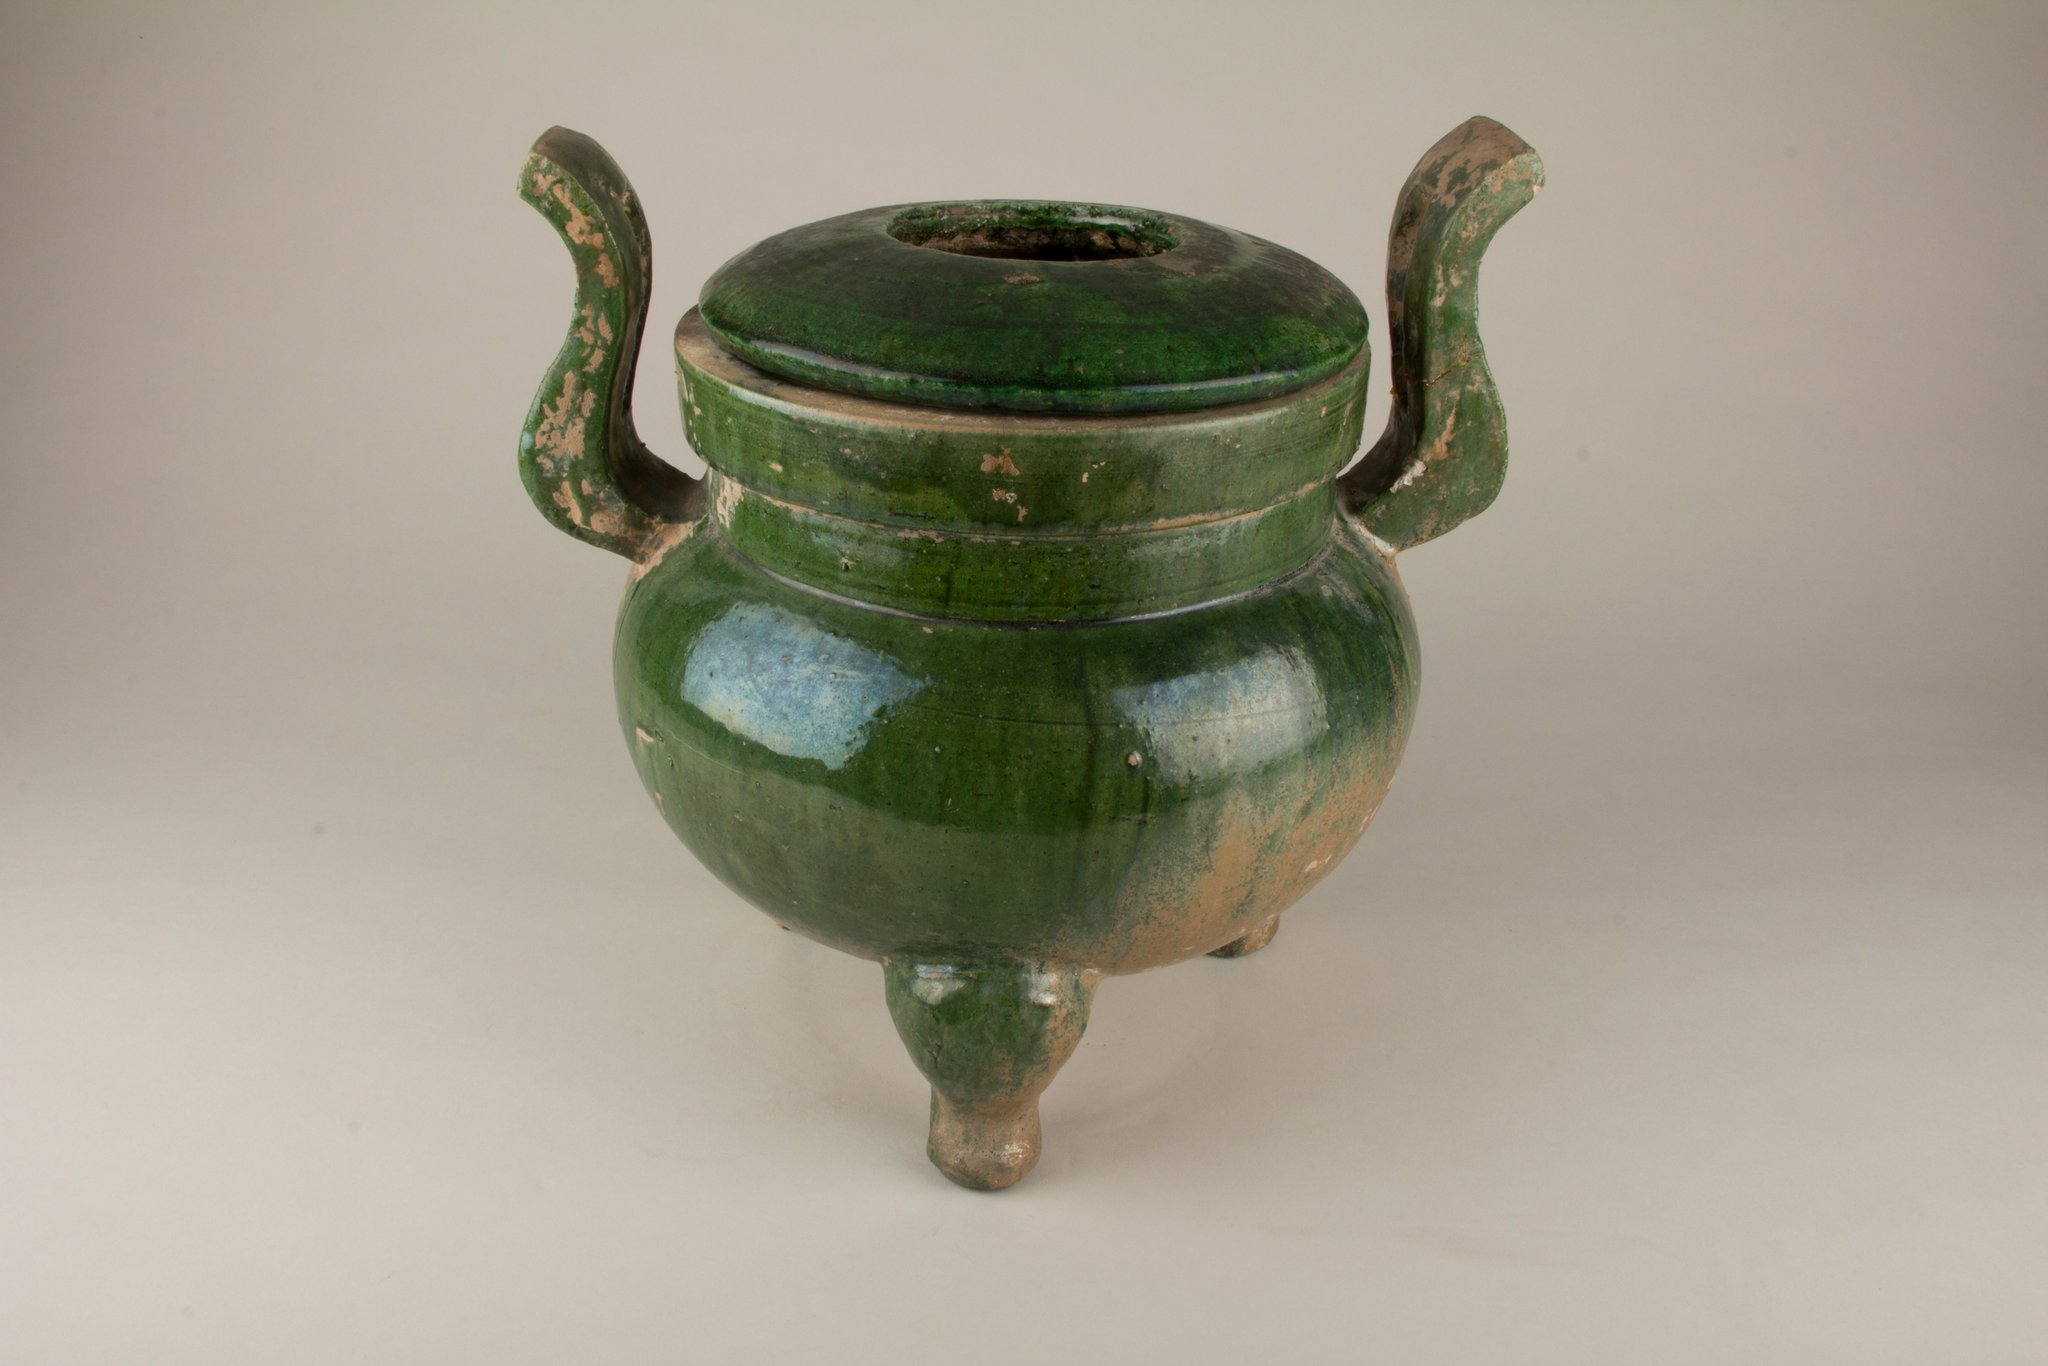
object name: incense burner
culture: chinese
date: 206 BCE-220 CE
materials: pottery